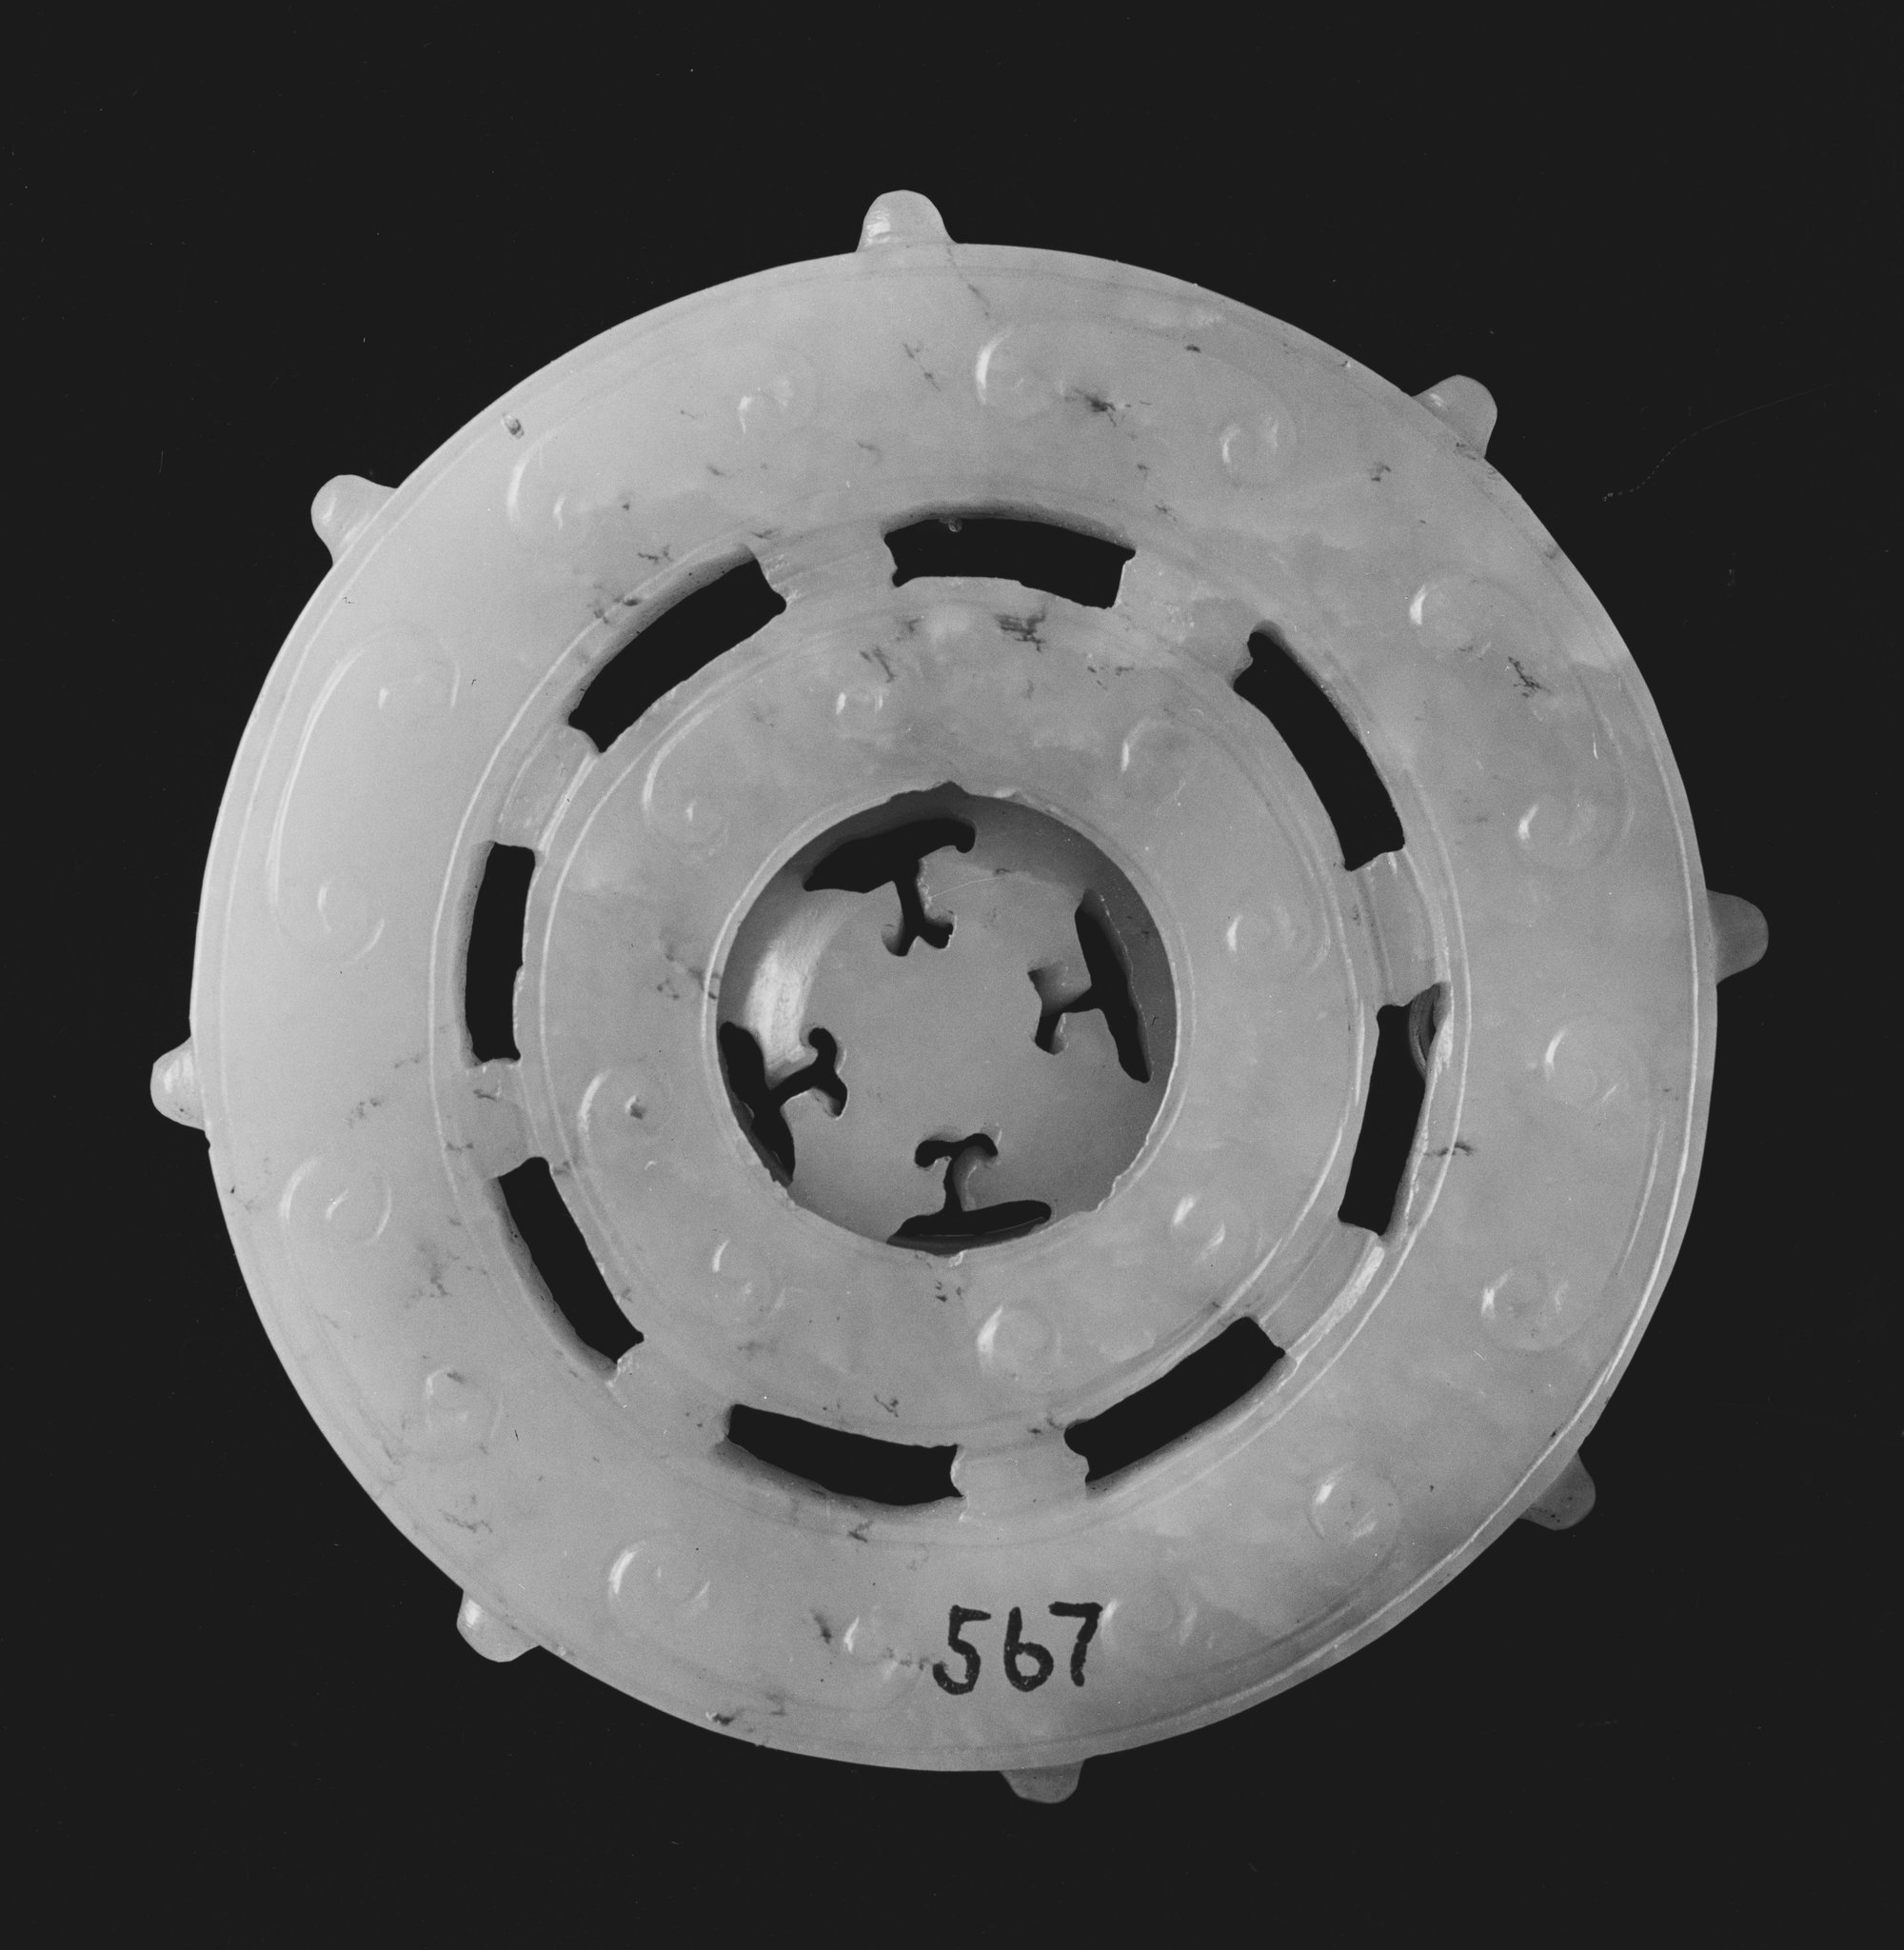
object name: necklace, bead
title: Amulet (Wheel)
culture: chinese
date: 1736-1795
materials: jade